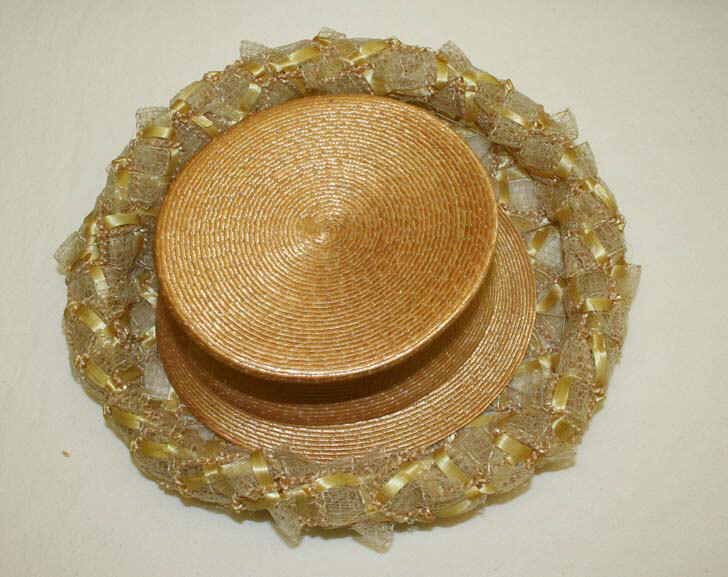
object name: hat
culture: american or european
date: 1880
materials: fiber